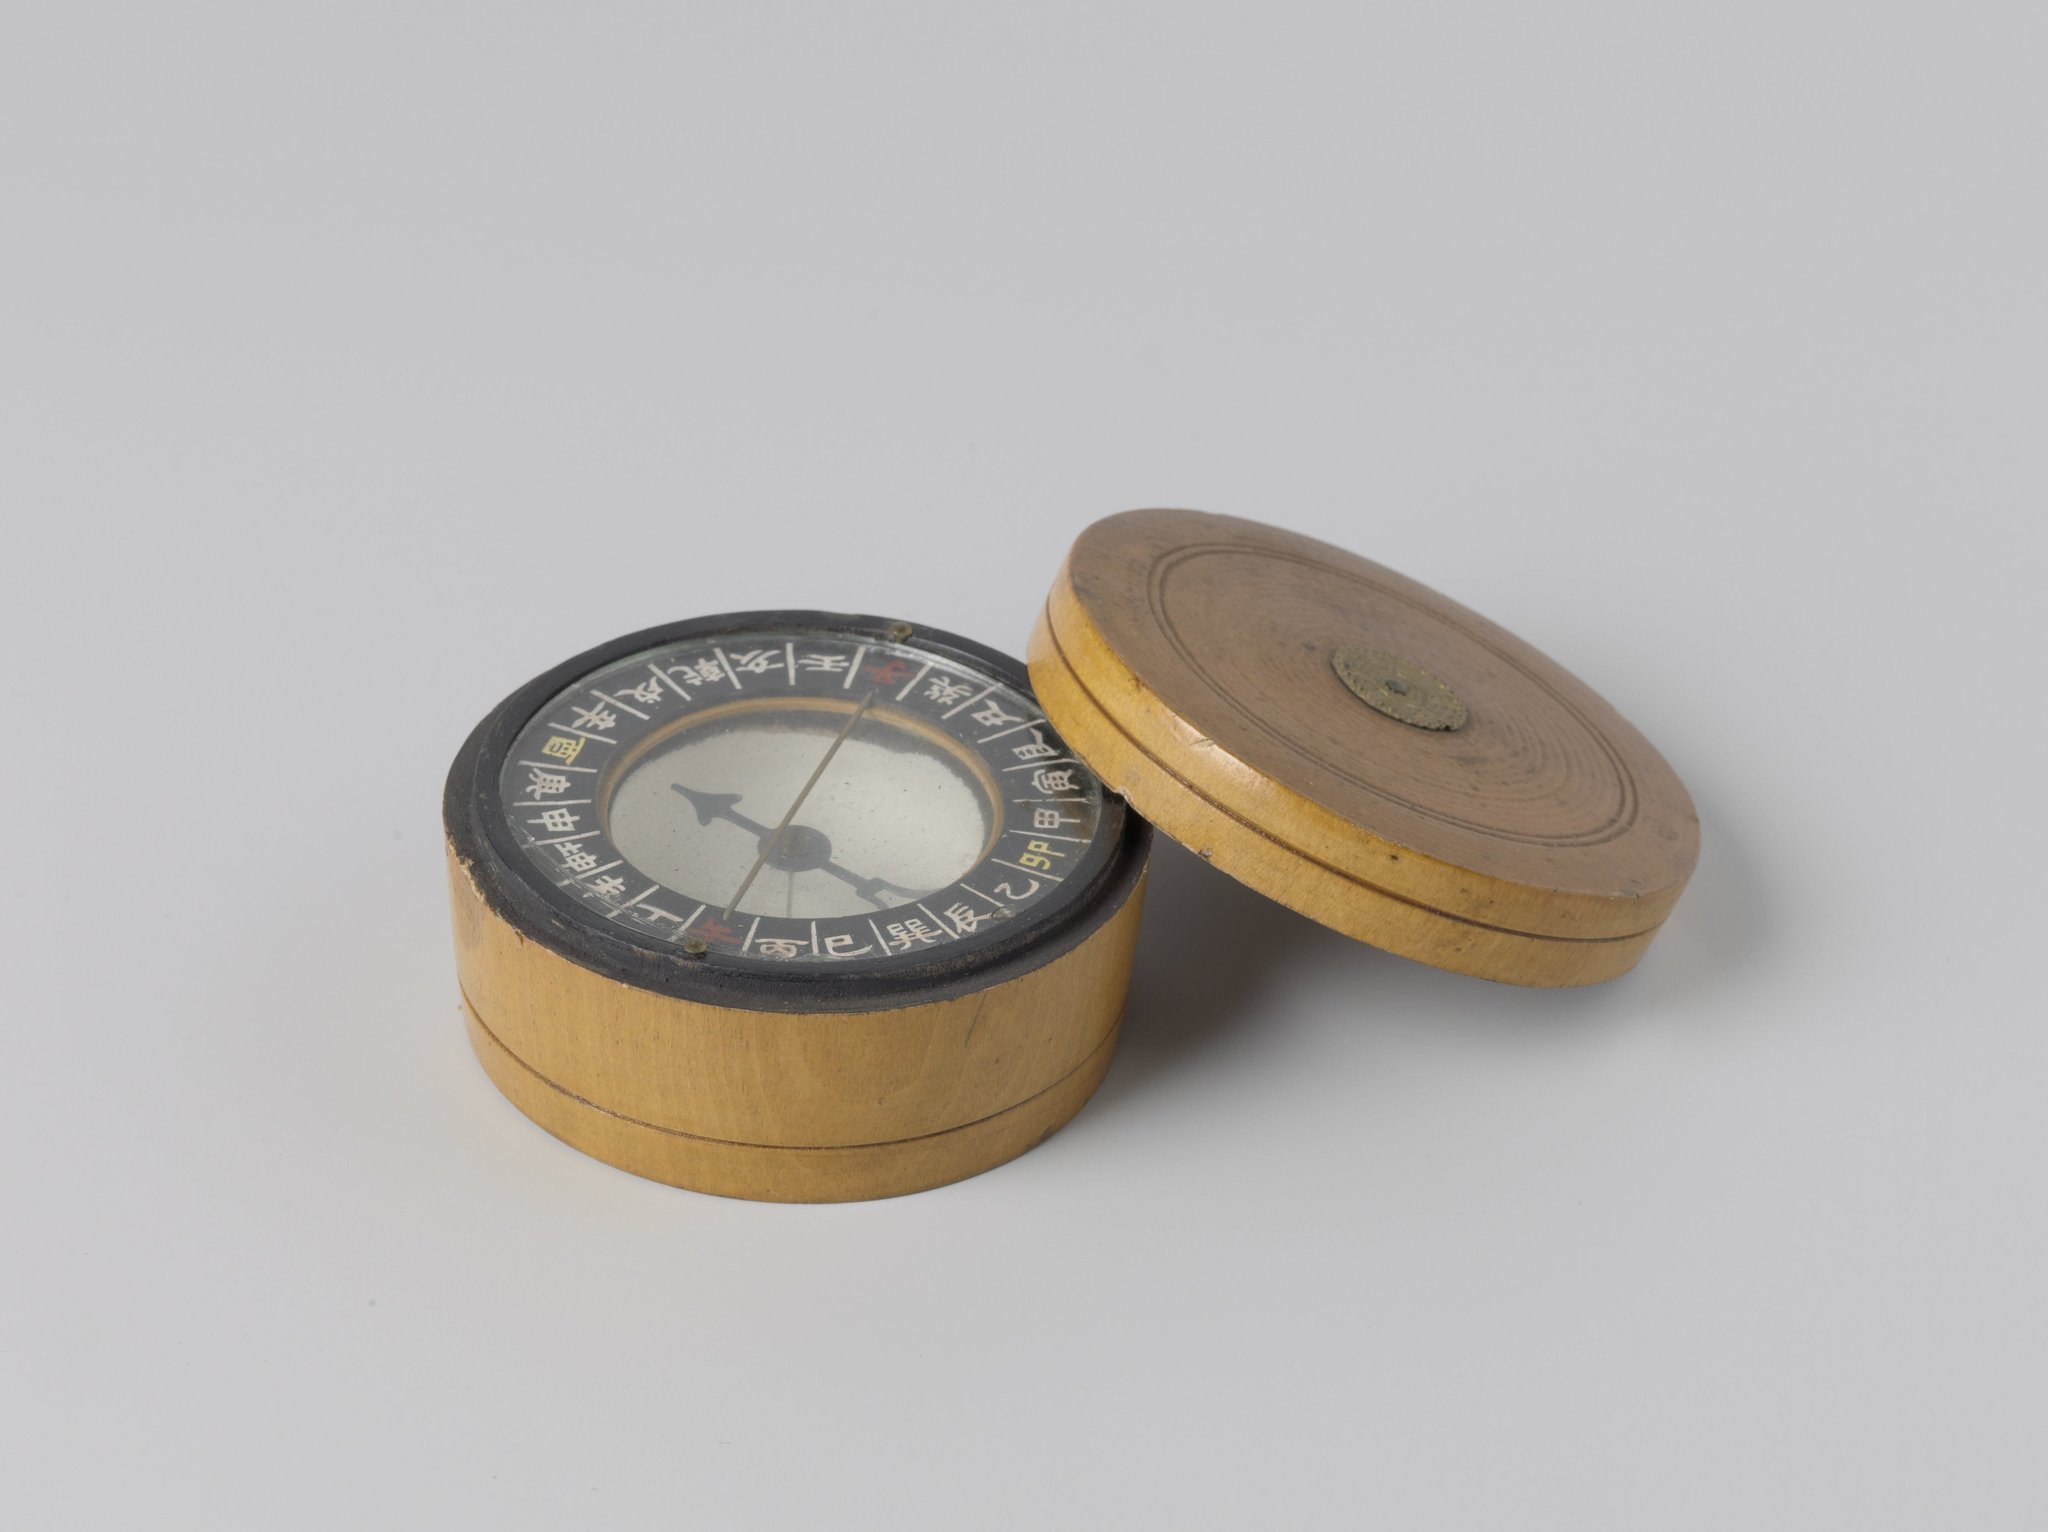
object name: compass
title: Chinese Compass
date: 1850-1899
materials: copper, glass, metal, wood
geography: yantai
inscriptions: inscription: ‘MADE BY/ Pae Sze Co./ CHEFOO’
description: Chinees kompas bestaand uit een kom, aan de binnenzijde wit beschilderd en bedekt met glas, met daarin een droge kompasnaald. Chinese kompassen kennen een onderverdeling in 24 windrichtingen. De windrichtingen zijn weergegeven in witte karakters, noord en zuid zijn weergegeven in rood, oost en west in geel. Noord-zuid wordt tevens weergegeven door een metalen draad. Aan de binnenzijde van het deksel is een stempel met daarop de naam van de maker Pae Sze Co. uit Chefoo, het huidige Yantai.